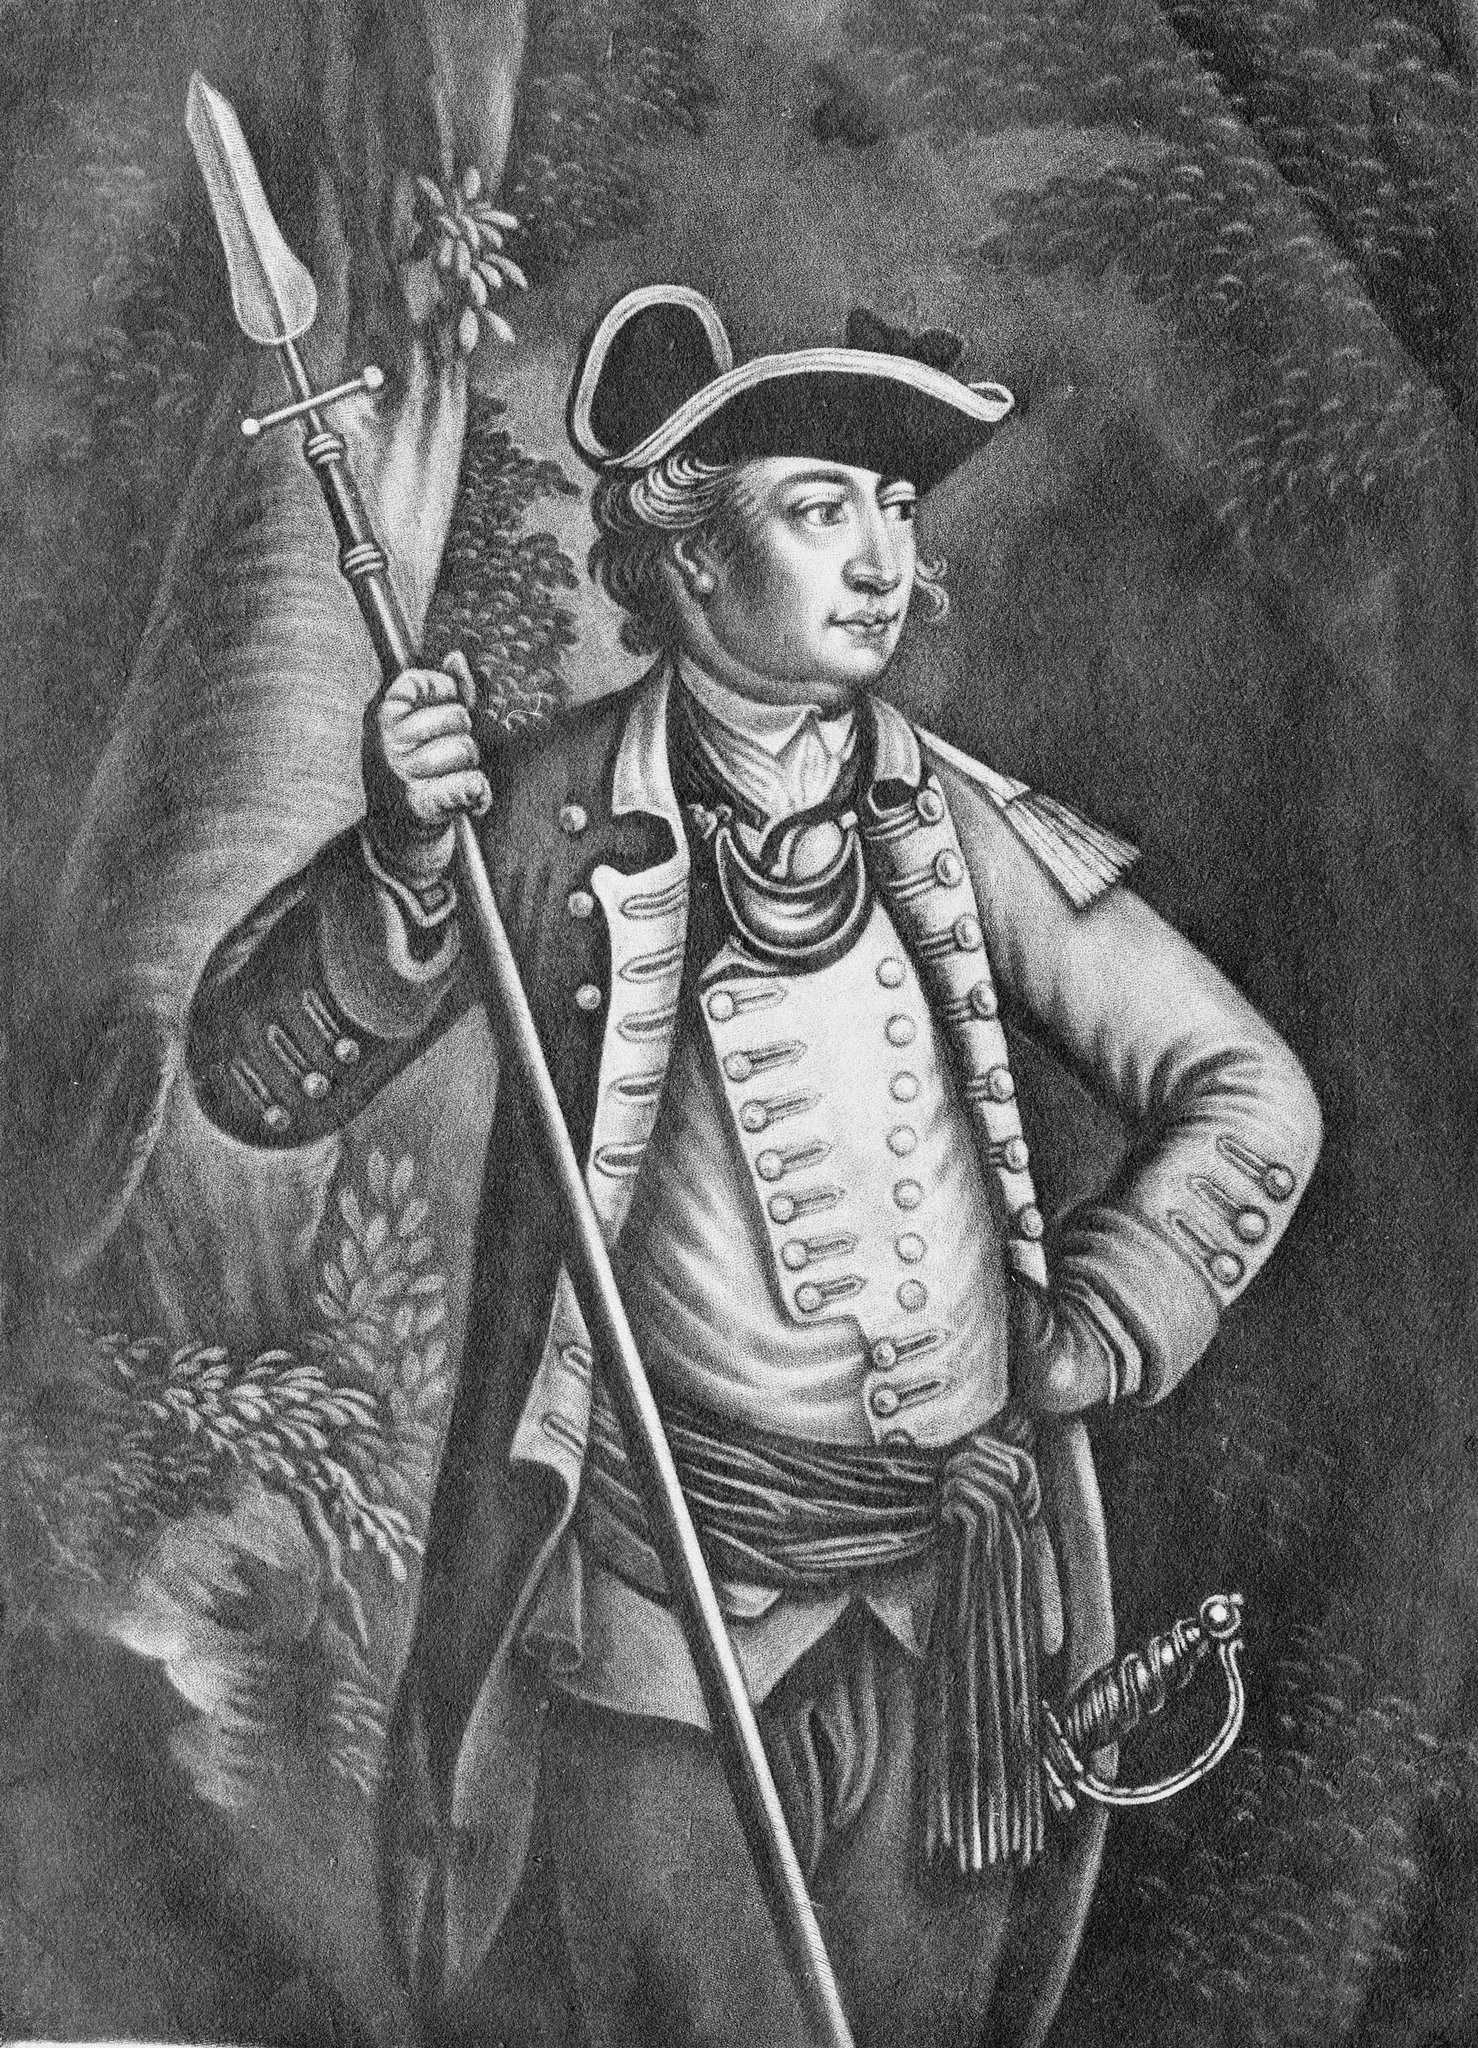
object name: print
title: Major General John Sullivan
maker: anonymous, 18th century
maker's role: engraver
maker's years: 1700-1800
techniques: mezzotint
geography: augsburg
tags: swords,men,generals